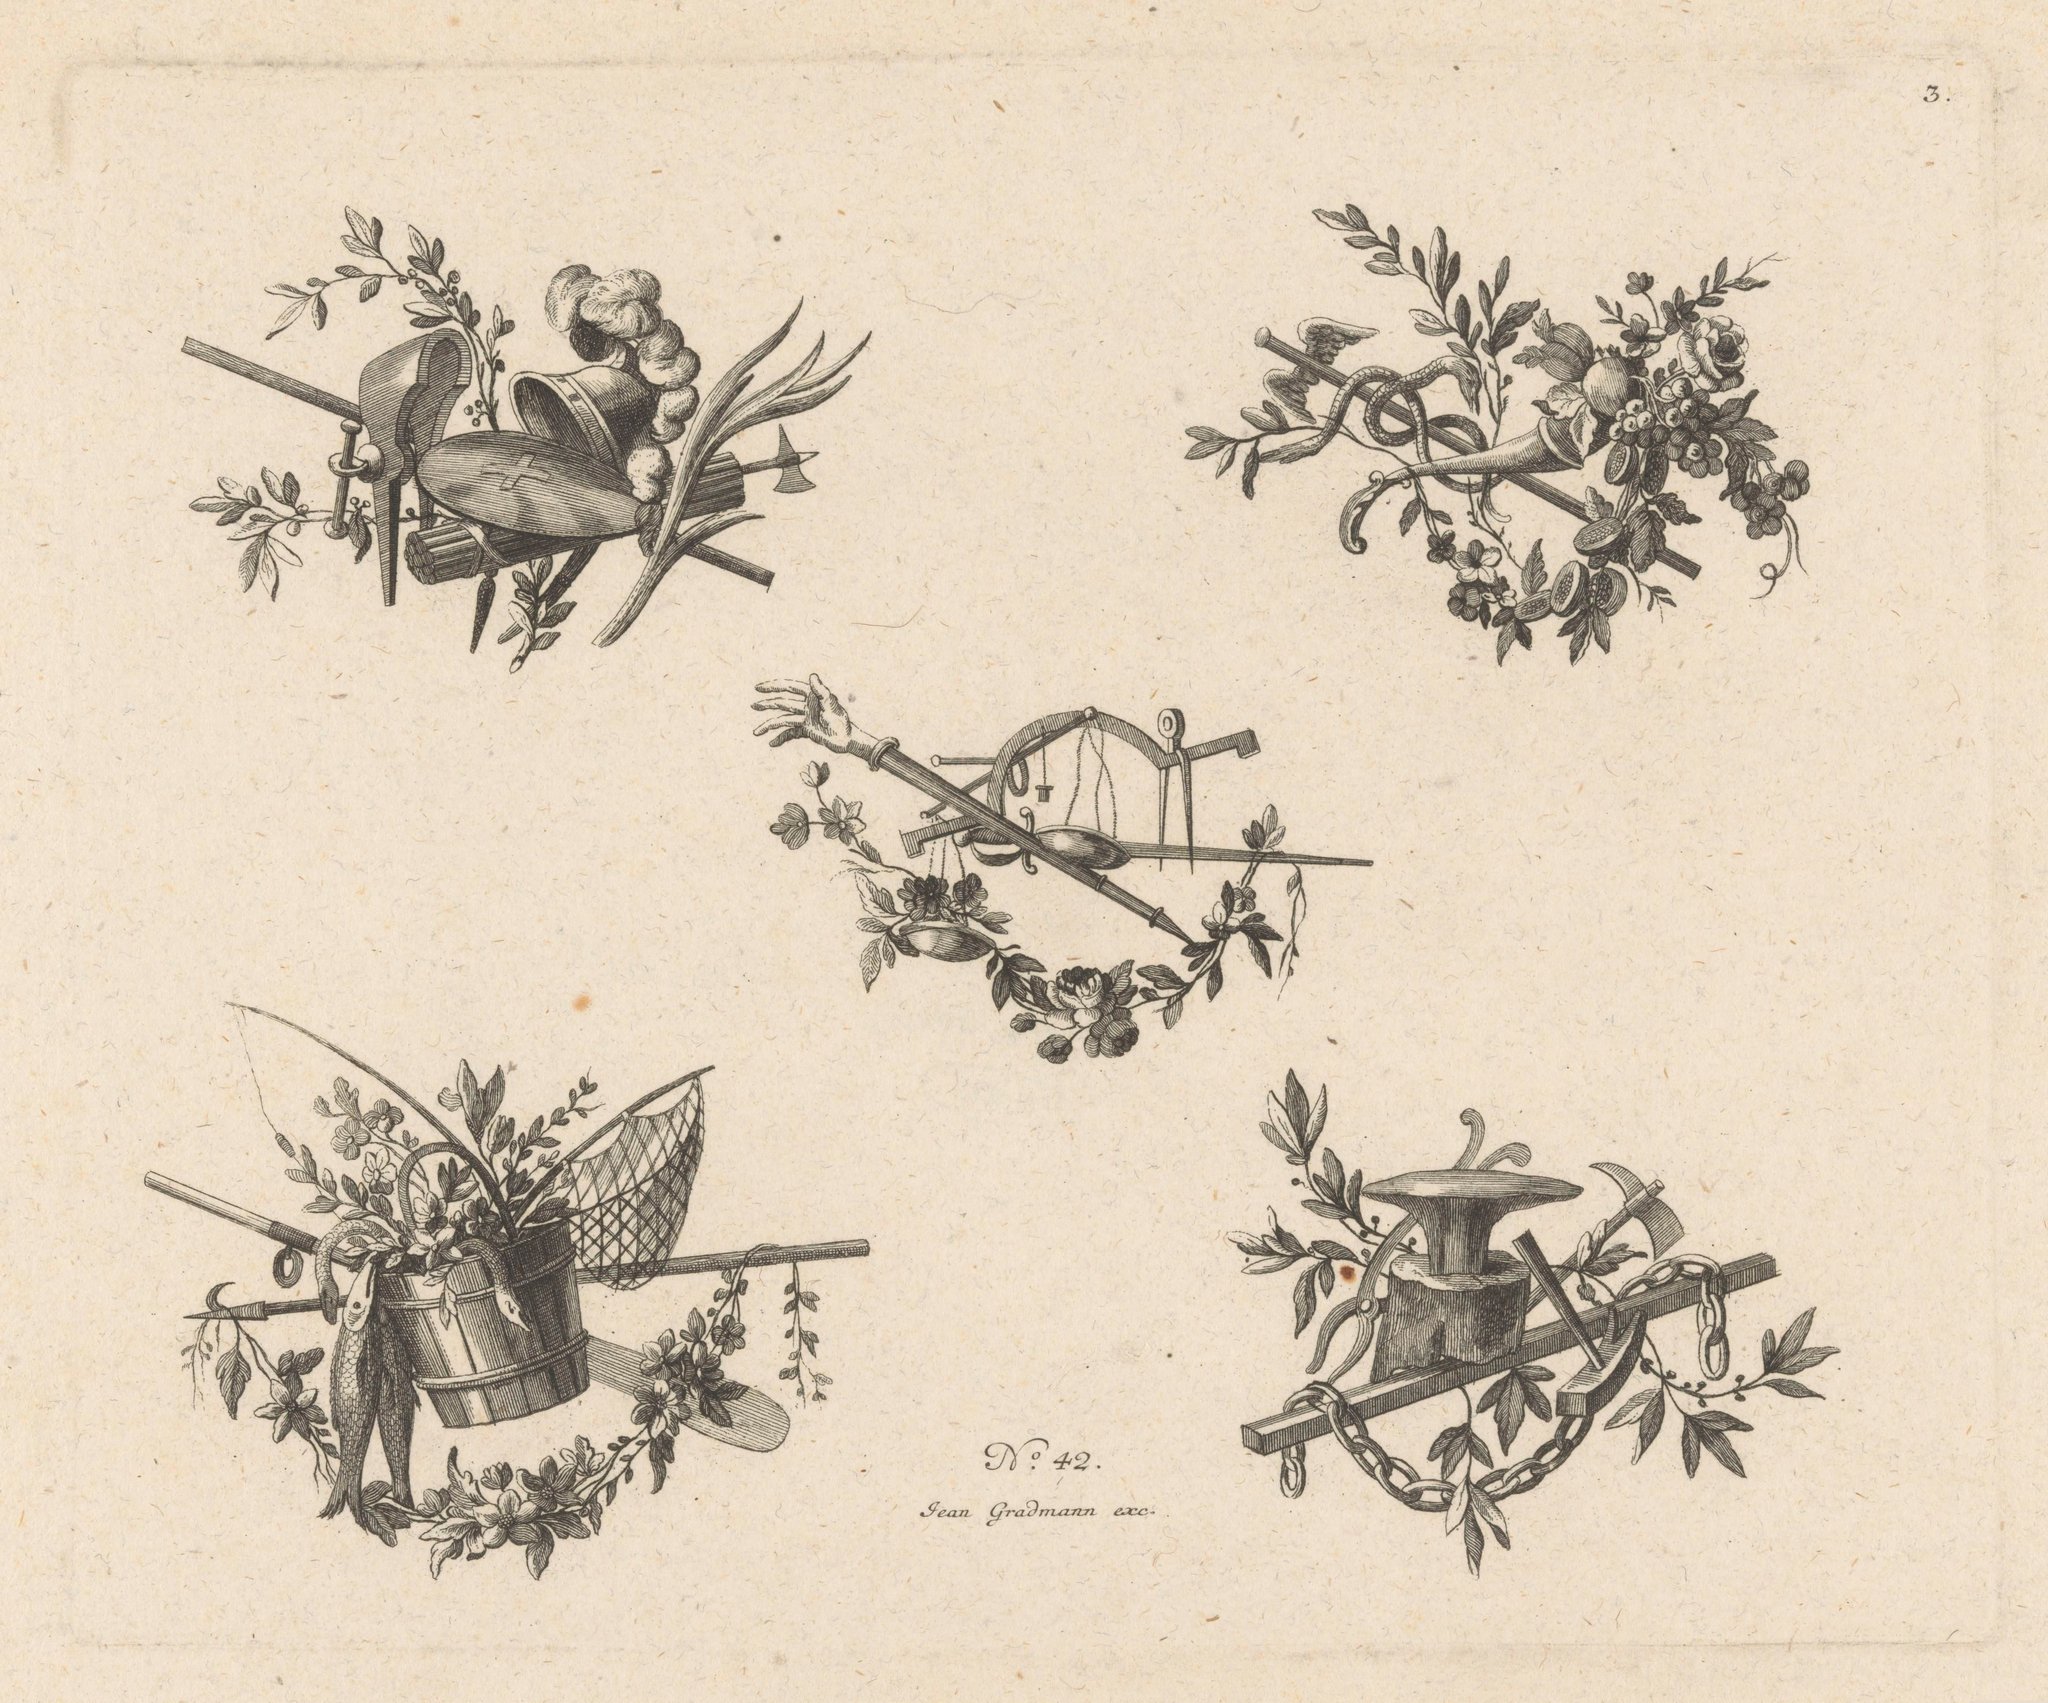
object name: print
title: Trofeeën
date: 1769-1842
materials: paper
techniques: etching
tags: trophy, i.e.: decorative arrangement of symbolic or typical objects ~ ornament, symbols, allegories of peace, 'pax'; 'pace' (ripa), fishing (sports)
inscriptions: collector's mark: Lugt 2228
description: Vijf trofeeën. Links boven met helm, schild en wapens. Rechts boven met attributen behorende bij de godin Pax. In het midden met meetkundige attributen. Links onder met attributen behorende bij de visserij. Rechts onder met attributen behorende bij de smeedkunst. Uitgeversnummer 42.